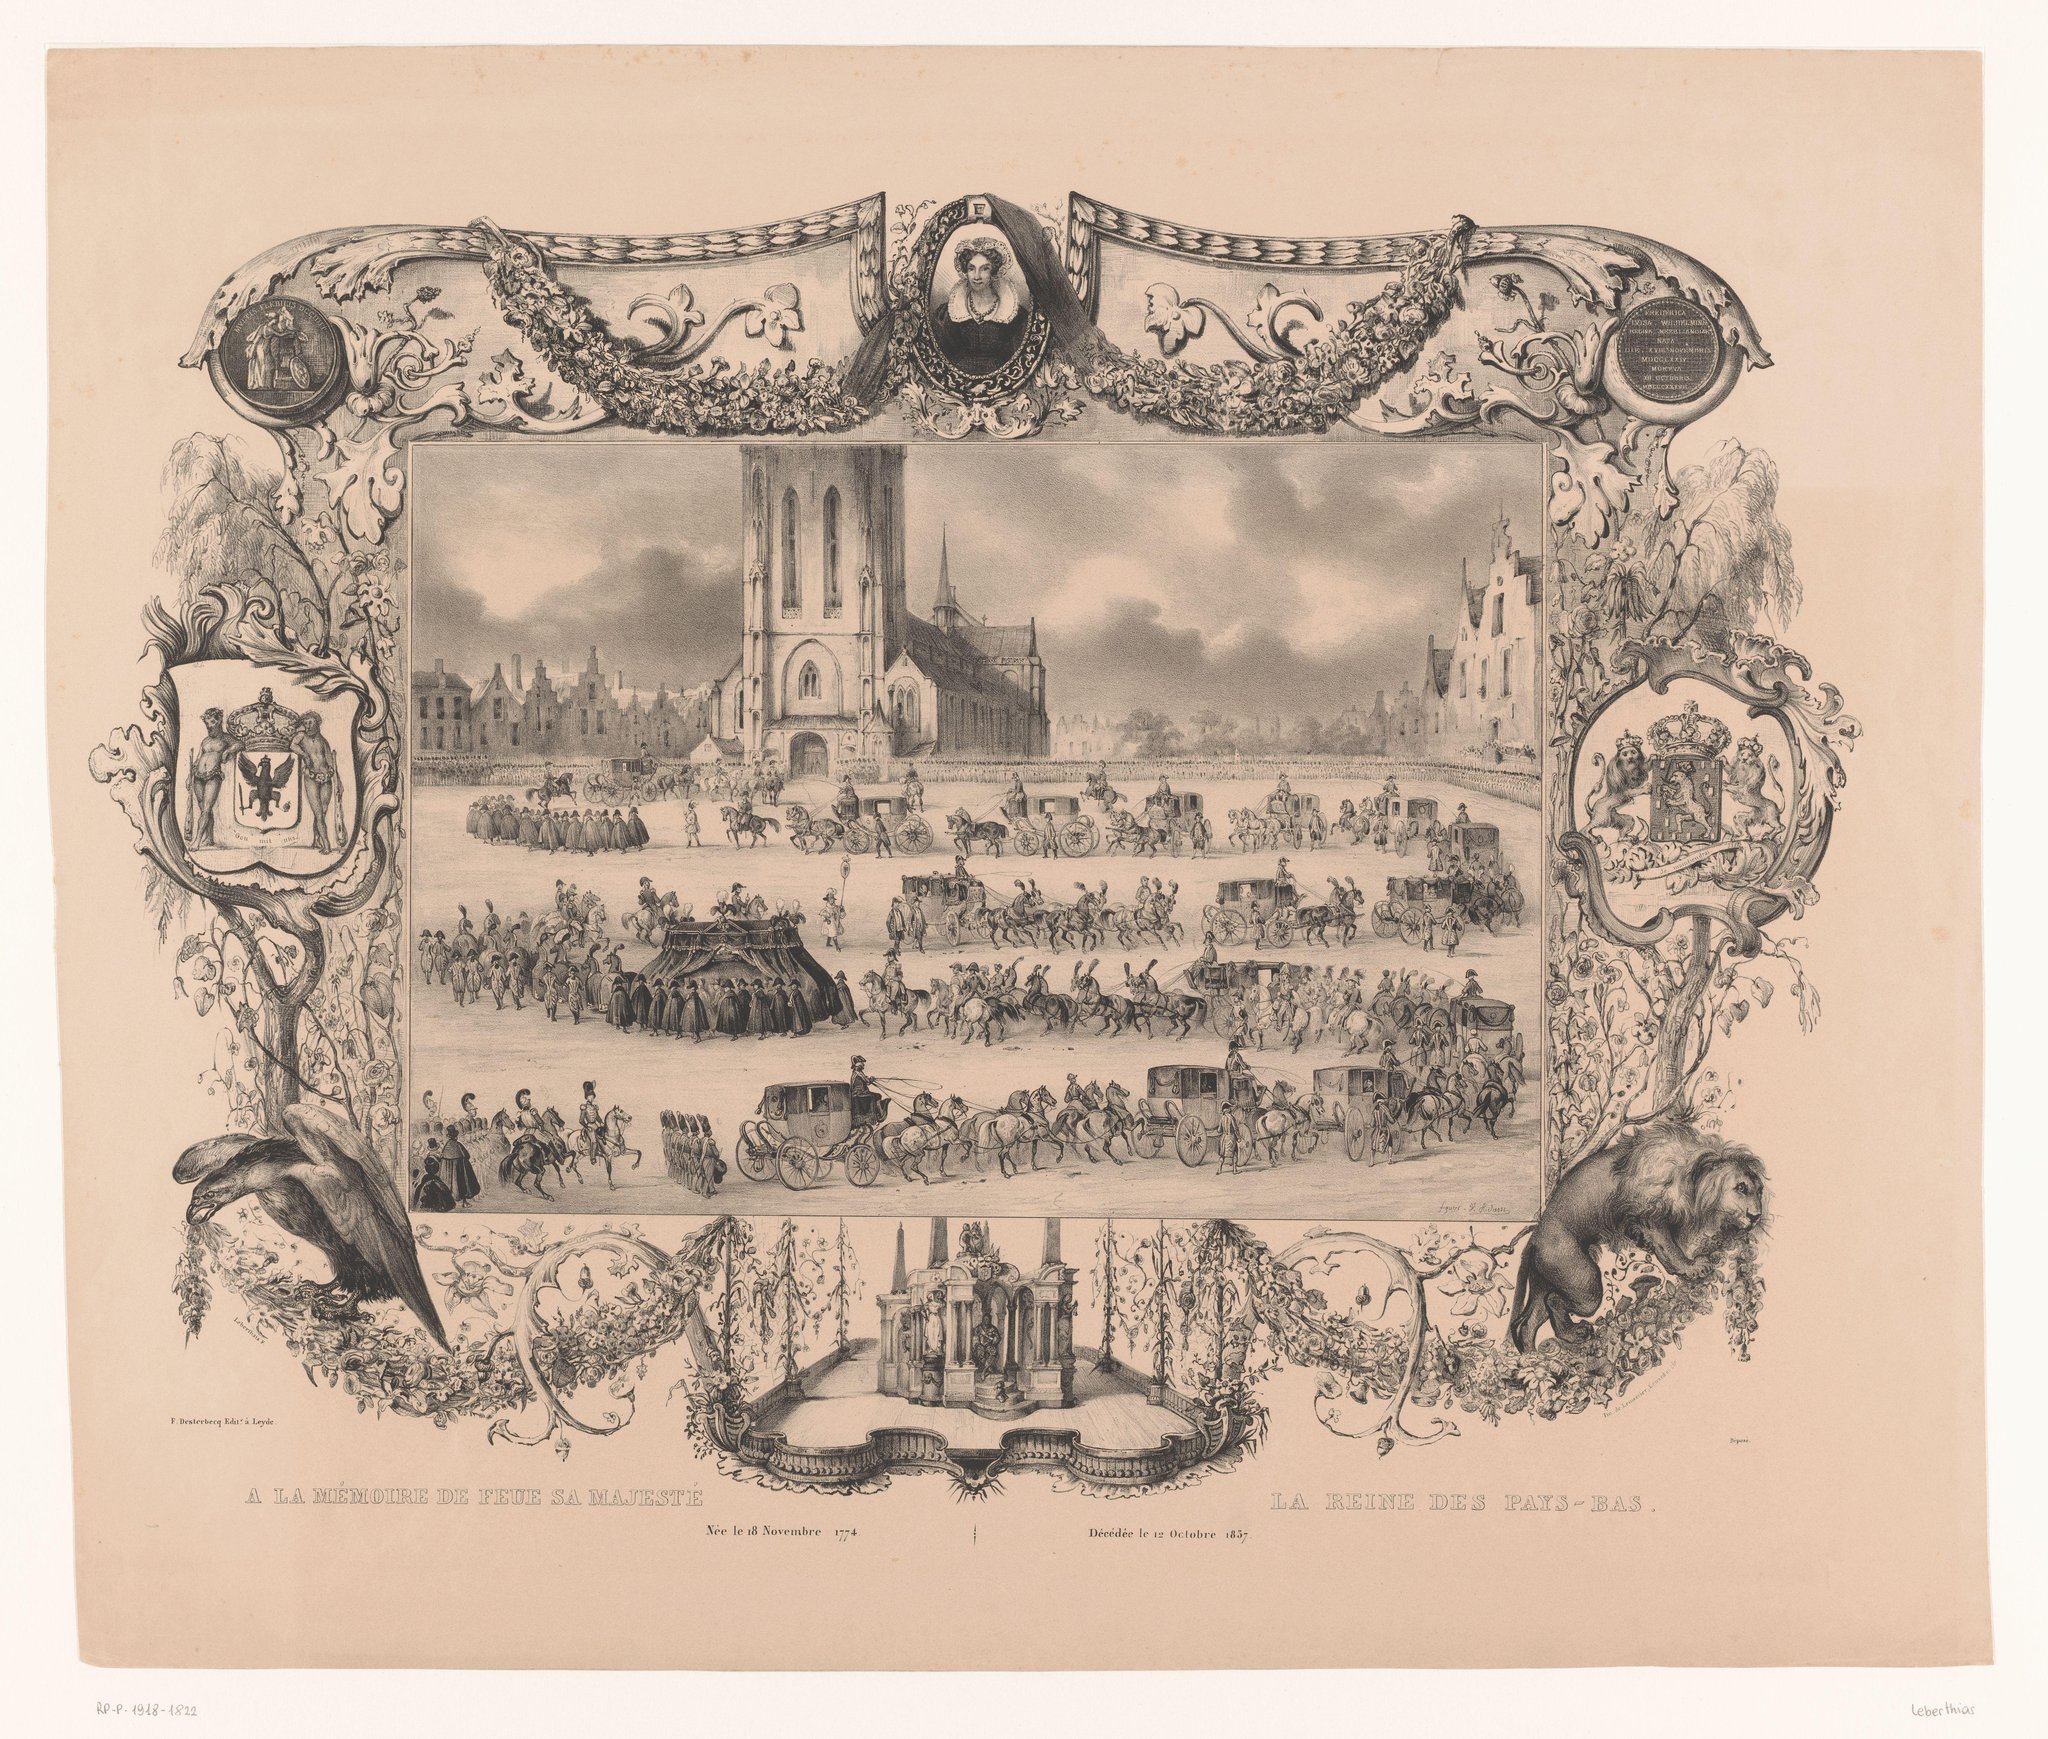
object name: print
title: A la mémoire de feue sa majesté la Reine des Pays-Bas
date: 1837-1839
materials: paper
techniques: lithograph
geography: paris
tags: the hague, wilhelmina frederica louisa (koningin der nederlanden), coat of arms (symbol of sovereignty), the place of worship and its equipment ~ christian churches, historical persons, cortege, funeral procession, grave-building, monumental tomb, burial rites, delft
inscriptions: check stamp: ‘F. Desterbecq [...]’, collector's mark: Lugt 2228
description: Begrafenisstoet op de markt voor de Nieuwe Kerk van Delft van konigin Wilhelmina van Pruisen. Rondom een versierde lijst met het portret van de koningin, familiewapens, medaillons, een adelaar, een leeuw en het grafmonument in de Nieuwe Kerk.